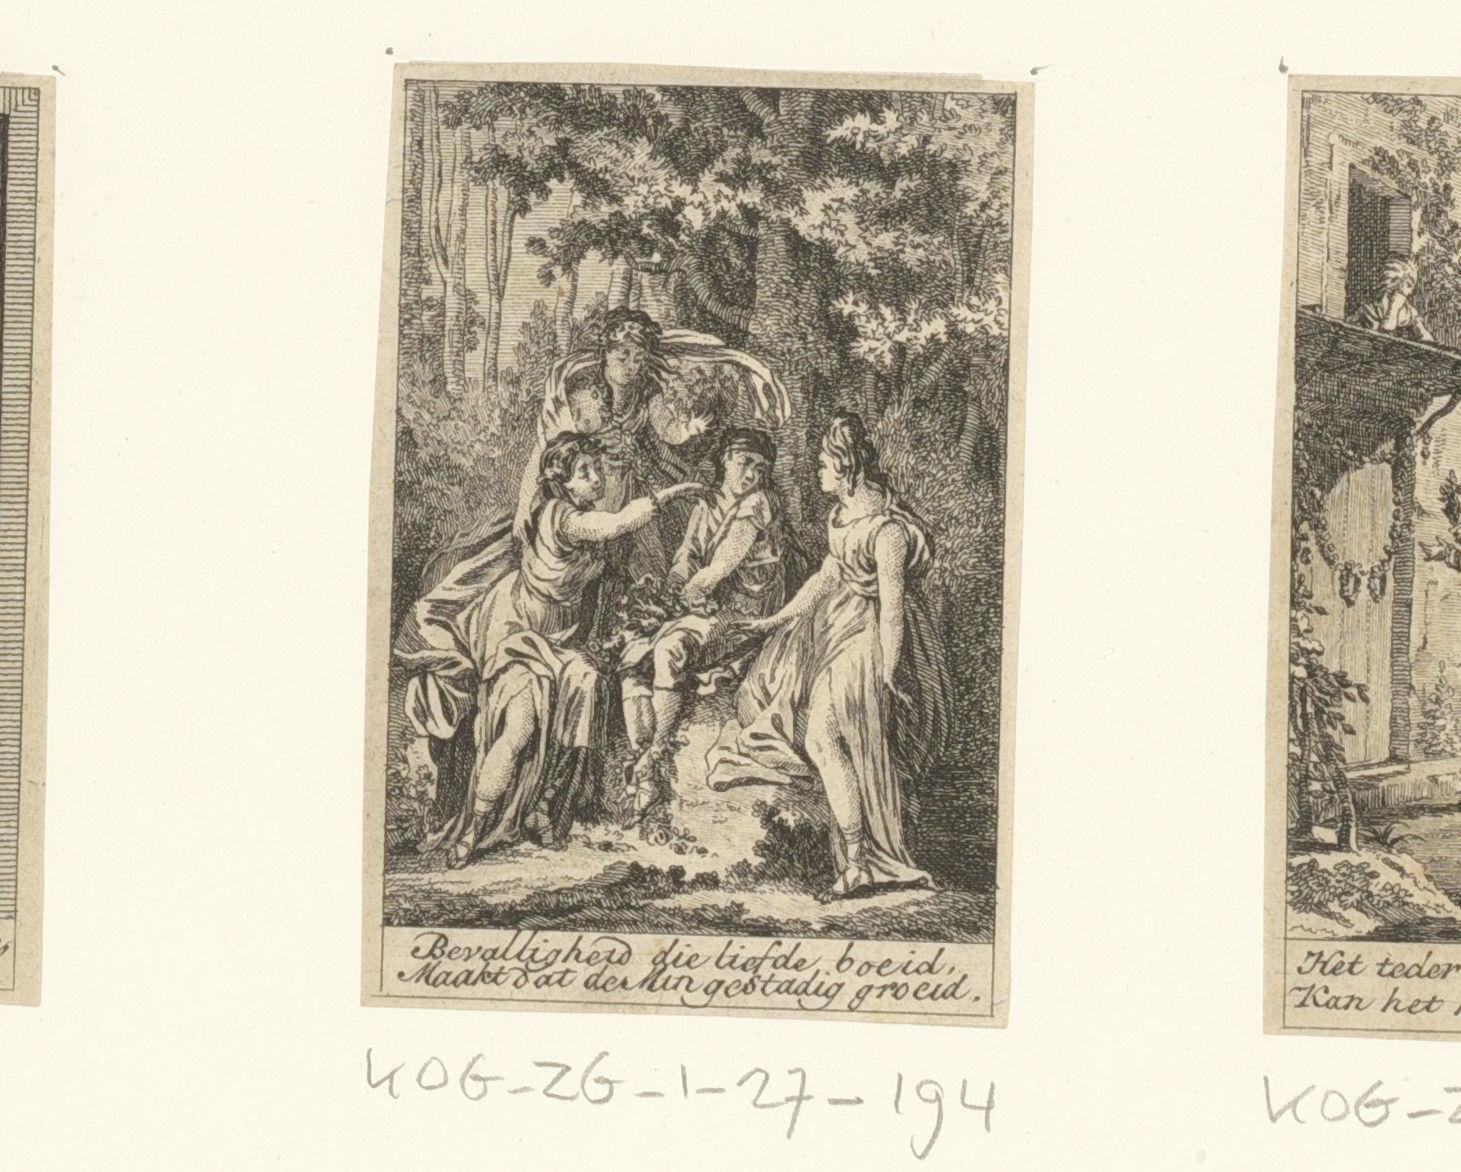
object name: print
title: Bevallige jonge vrouwen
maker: Anonymous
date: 1725-1799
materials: paper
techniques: engraving, etching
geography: netherlands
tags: courting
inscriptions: collector's mark: Lugt 1641, collector's mark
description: Gebruikt als illustratie in een onbekende almanak.